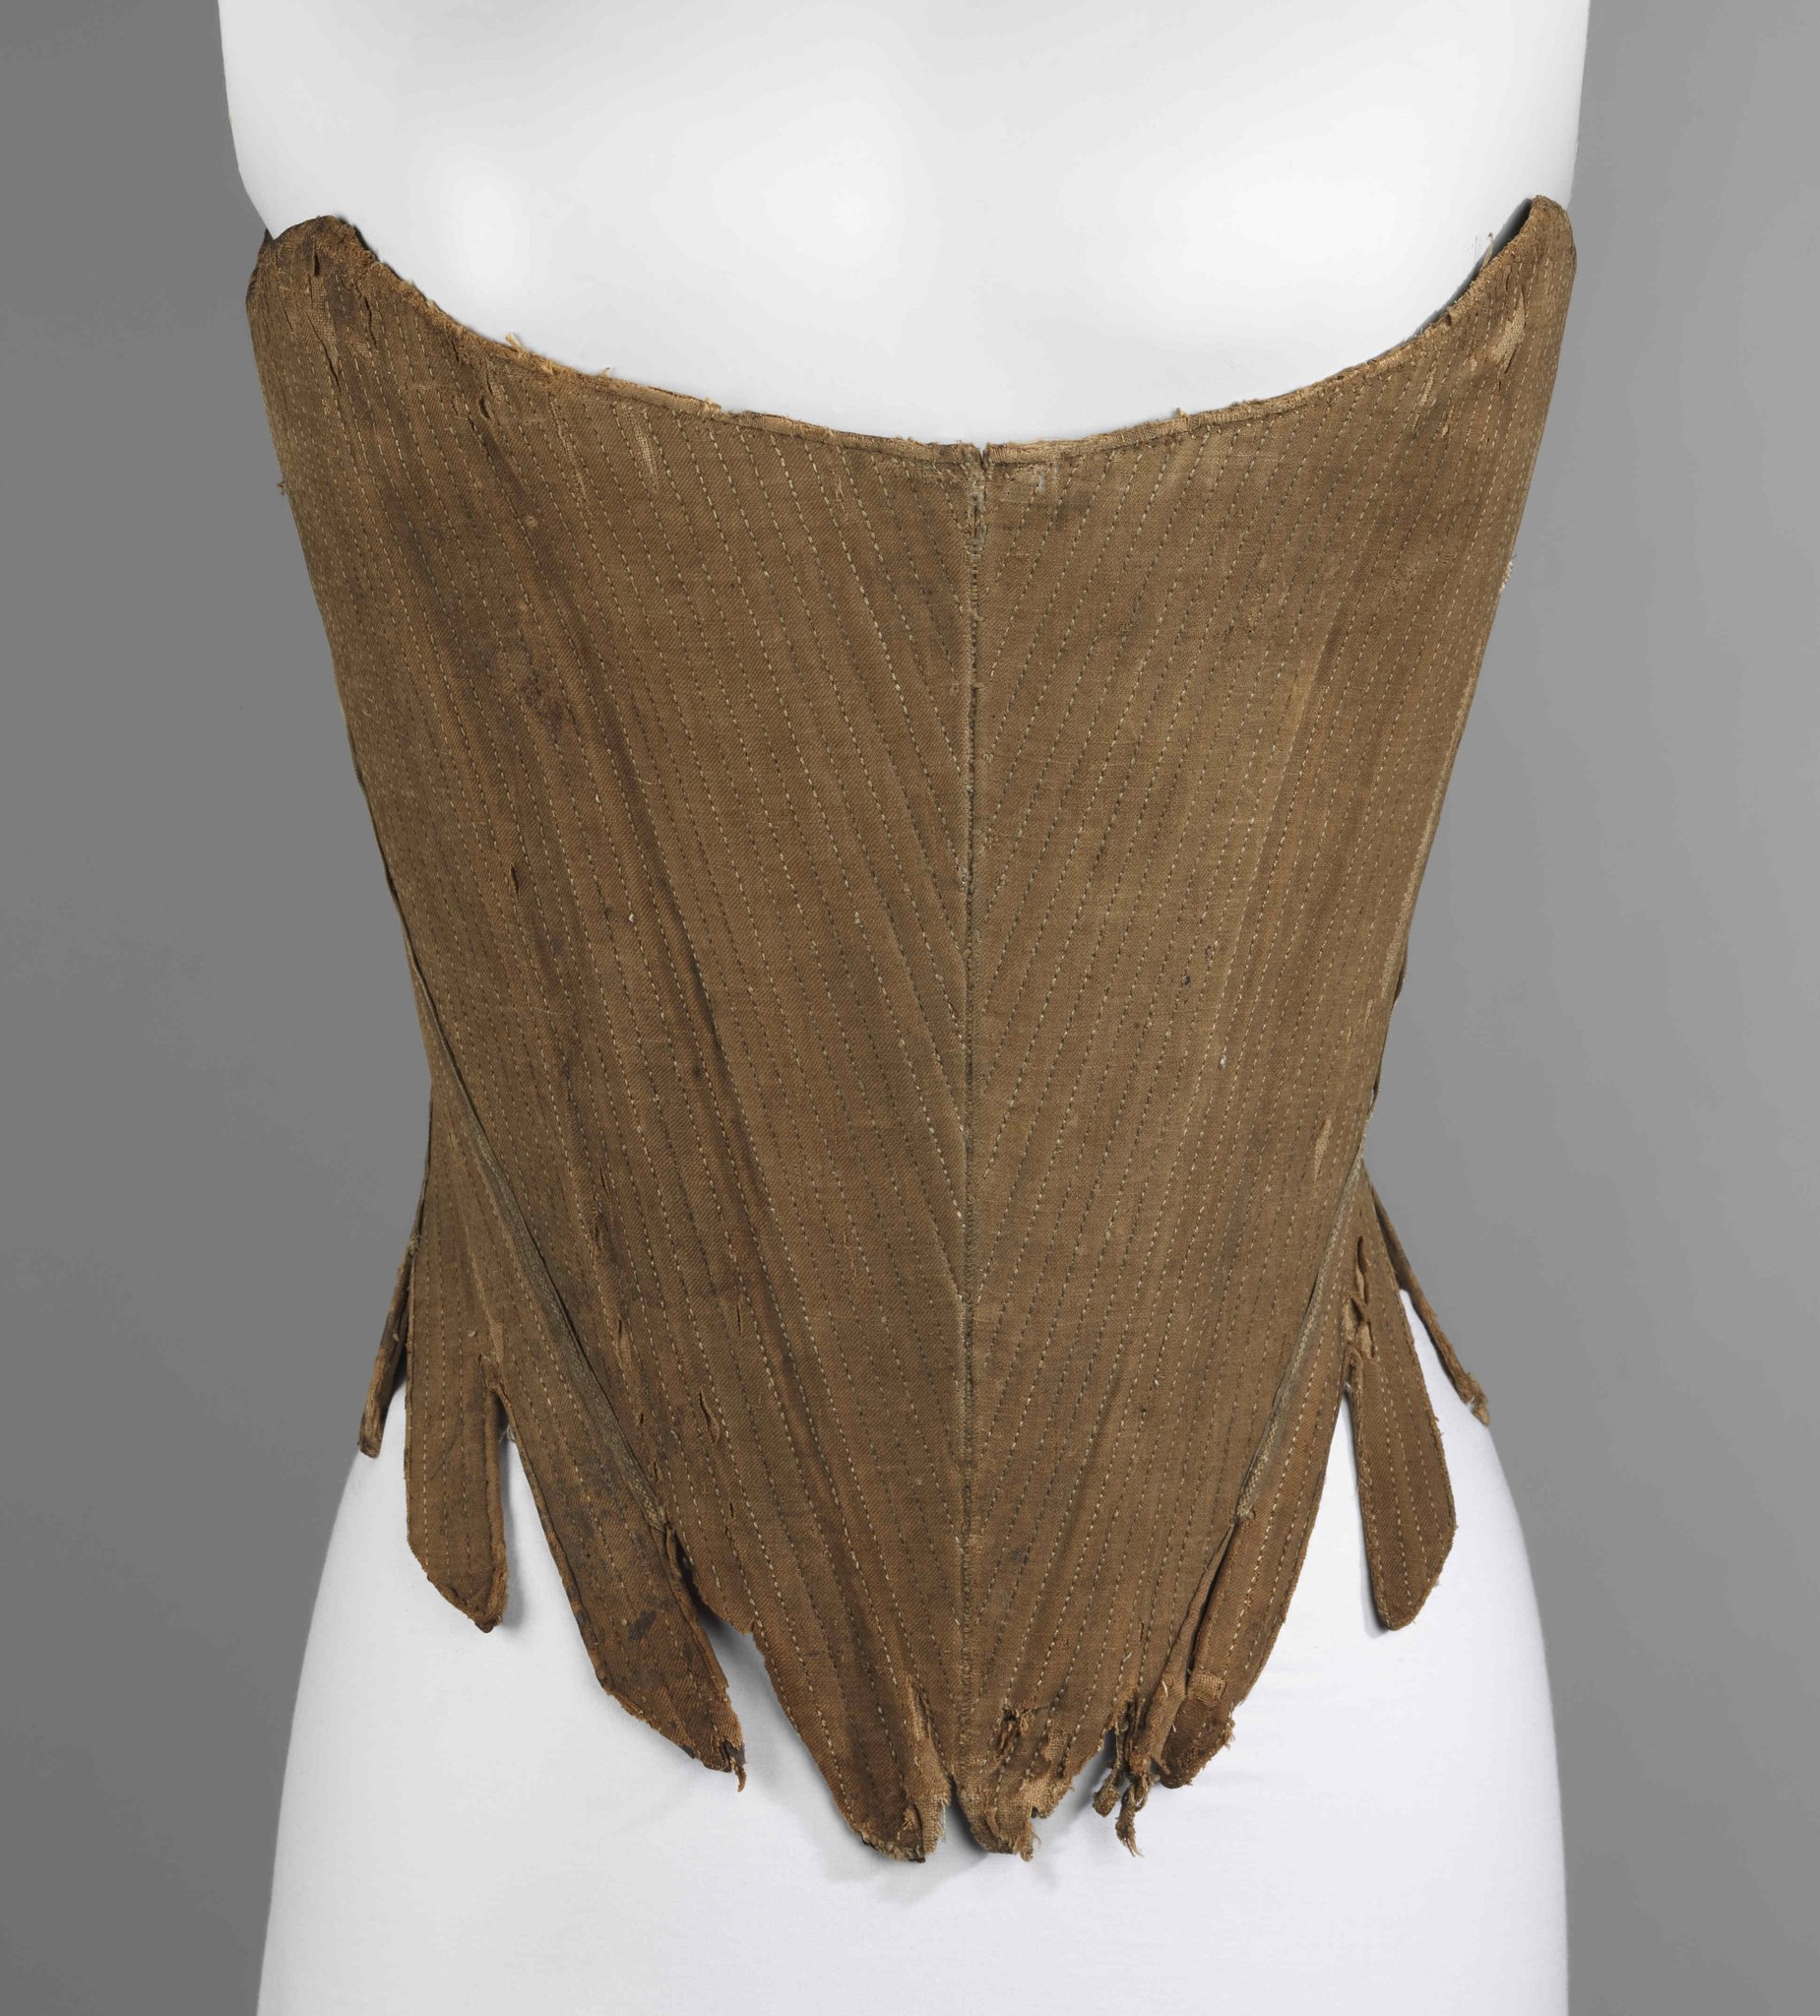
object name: corset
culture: american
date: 1701-1725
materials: cotton, linen